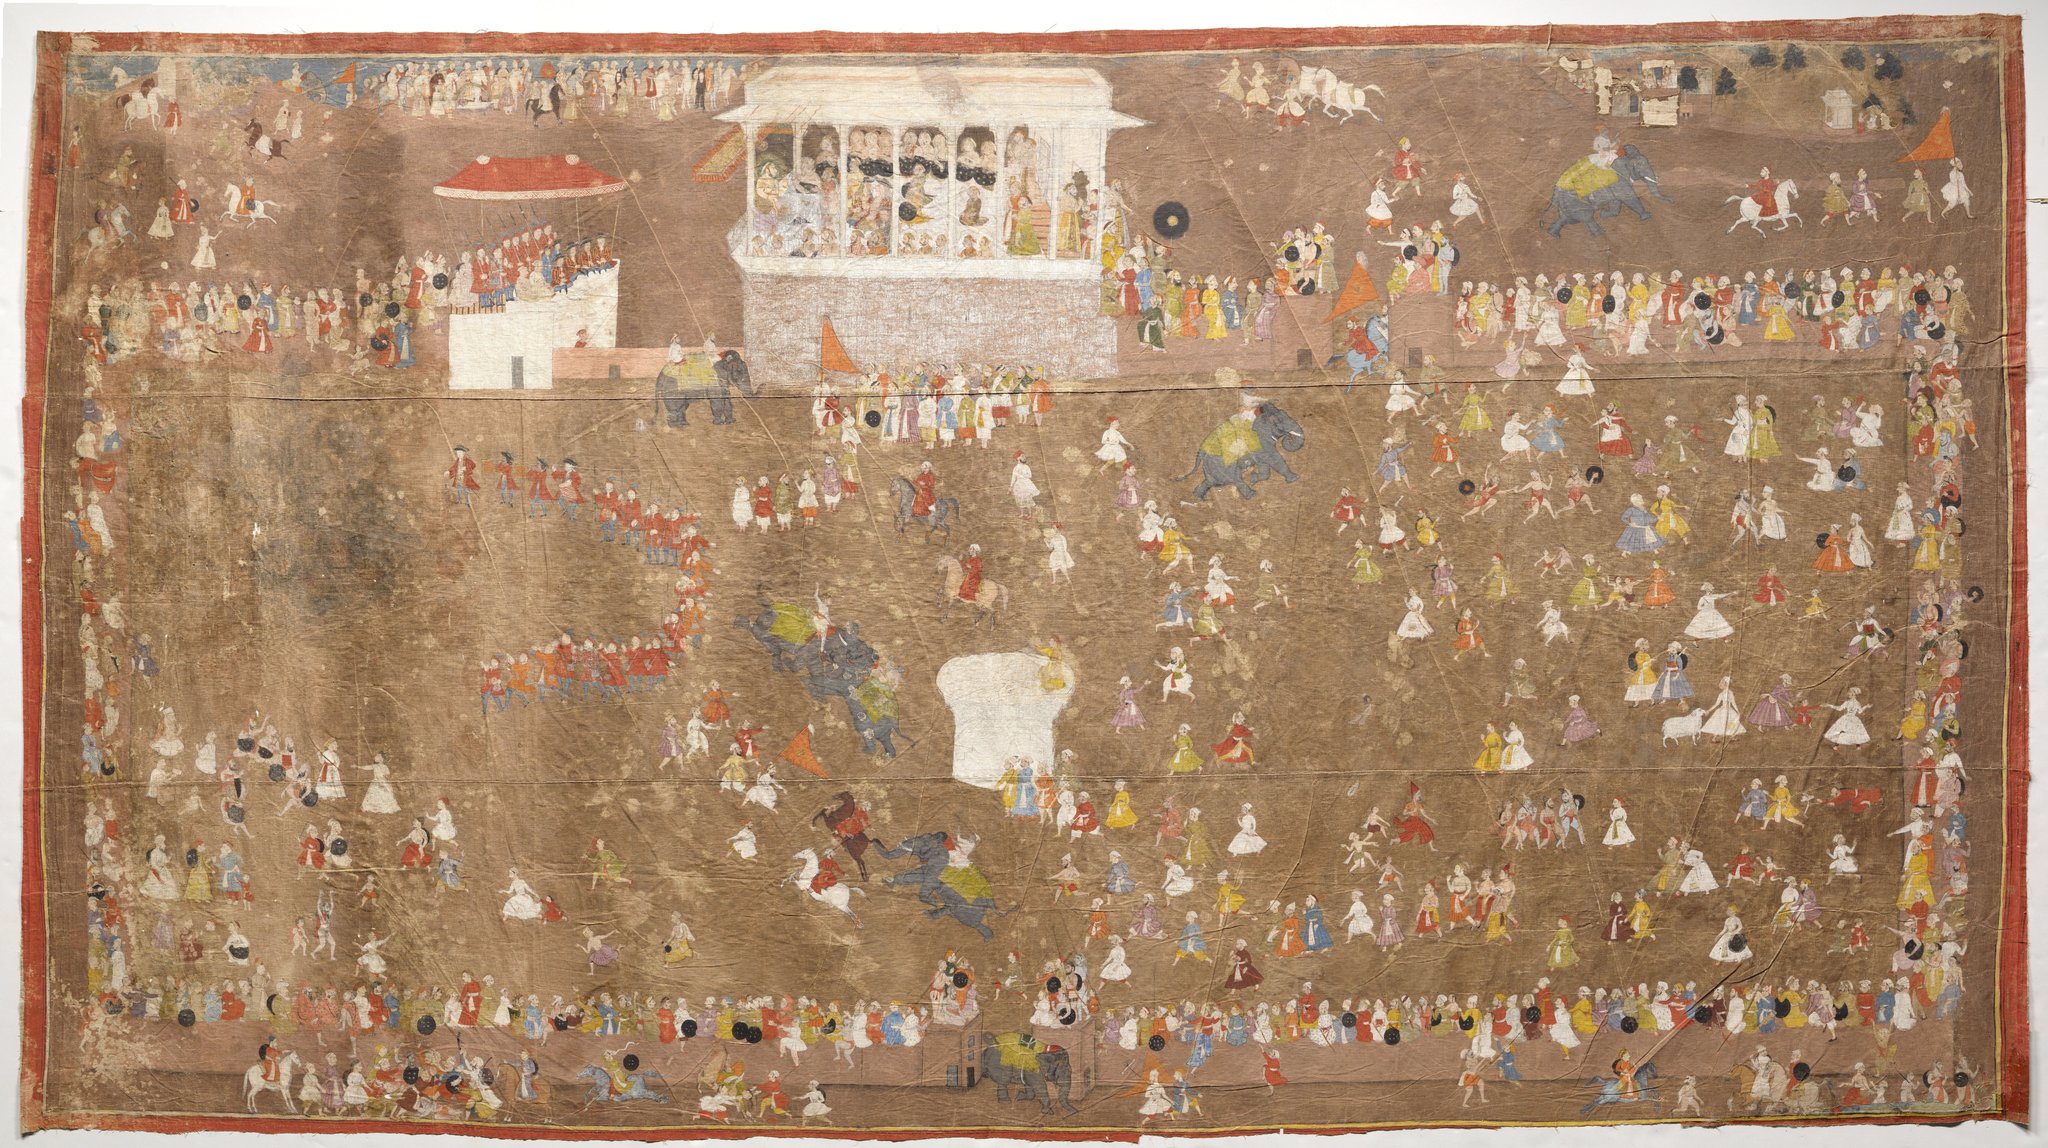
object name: painting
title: Joan Ketelaar’s Embassy to the King of Udaipur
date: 1711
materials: cotton, paint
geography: udaipur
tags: maharana rana sangram singh ii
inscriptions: inscription: ‘kimata 175’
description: In 1711 the VOC sent a delegation to India’s most important ruler, the Mughal emperor. Joan Josua Ketelaar, an expert in the Hindustani and the Persian language, was in charge. En route the mission passed through the city of Udaipur and was received by the local ruler. Here Ketelaar and the Indian king sit in a pavilion. For decades to come, Indian painters in Udaipur continued to paint the exotic Dutchmen based on this visit.